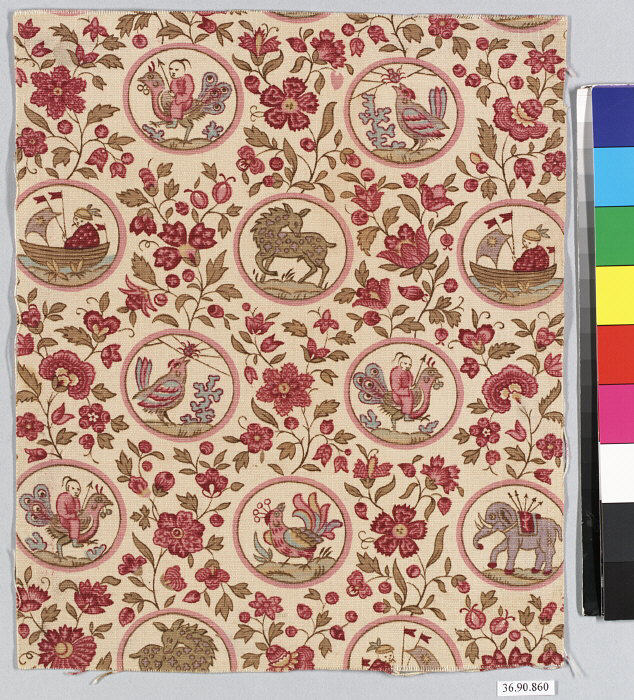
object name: piece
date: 1801-1900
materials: cotton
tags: birds,elephants,flowers,leaves